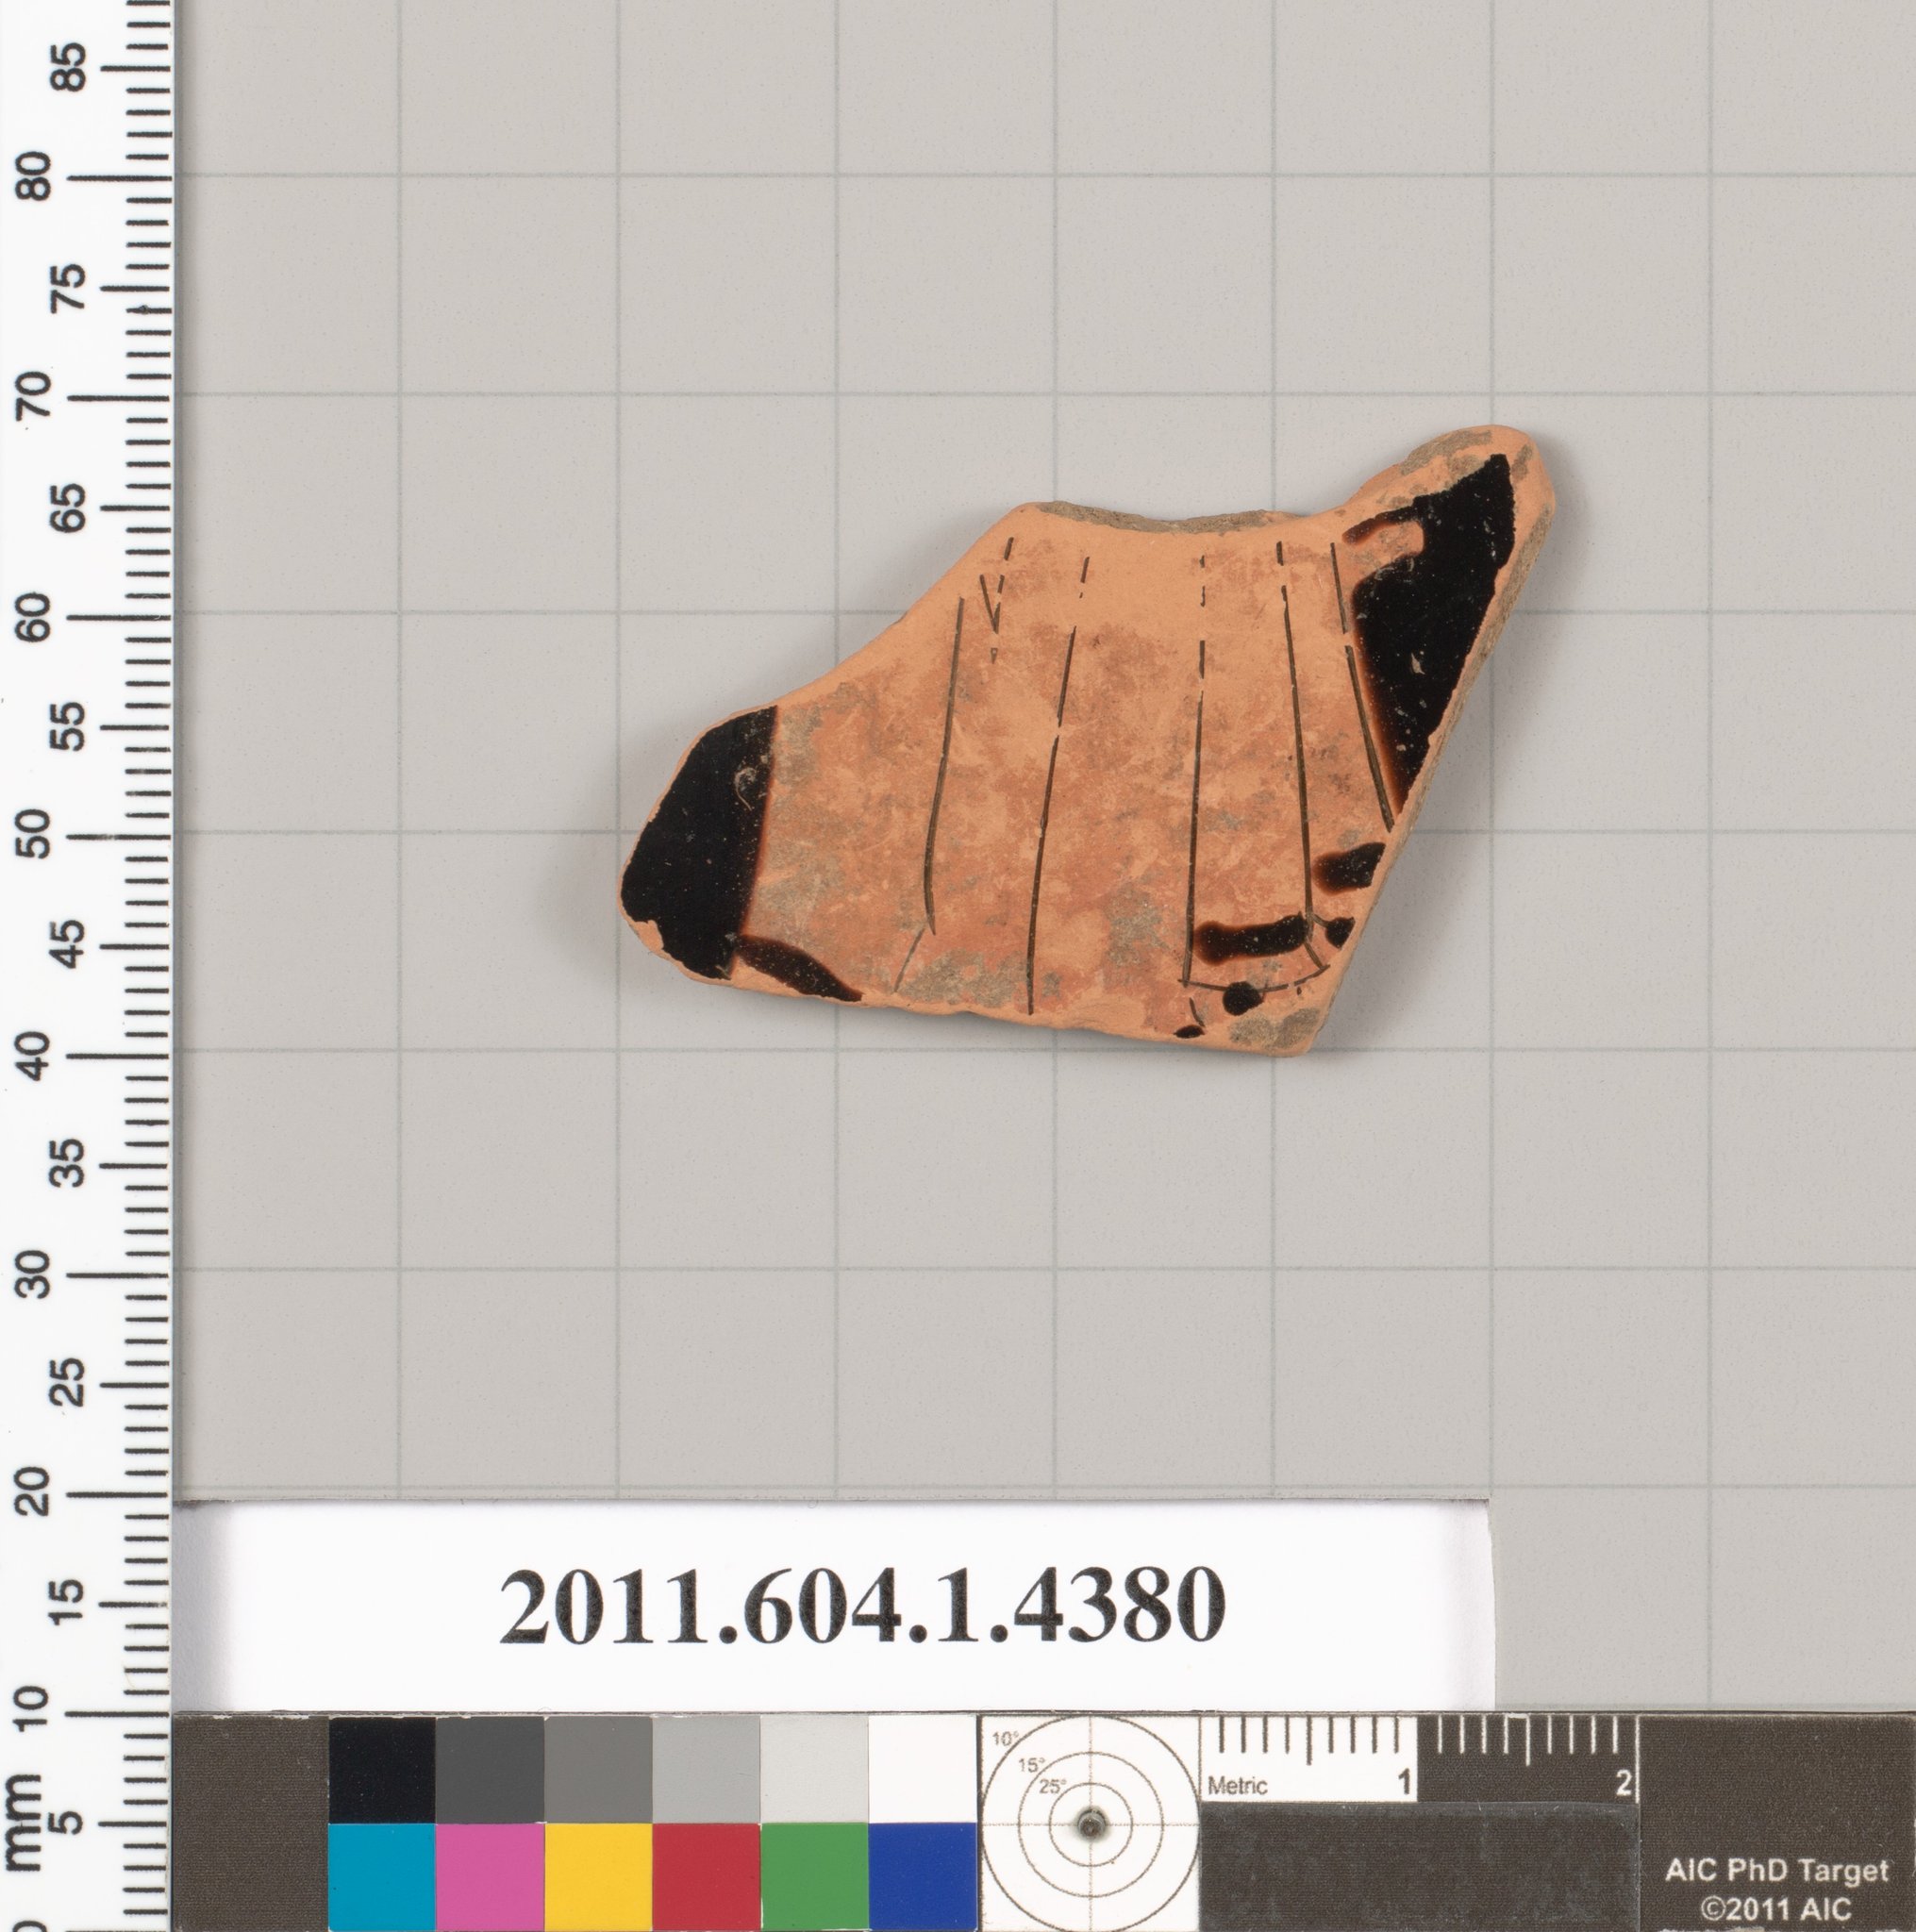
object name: kylix fragment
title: Terracotta fragment of a kylix (drinking cup)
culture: greek, attic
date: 475-451 BCE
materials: terracotta